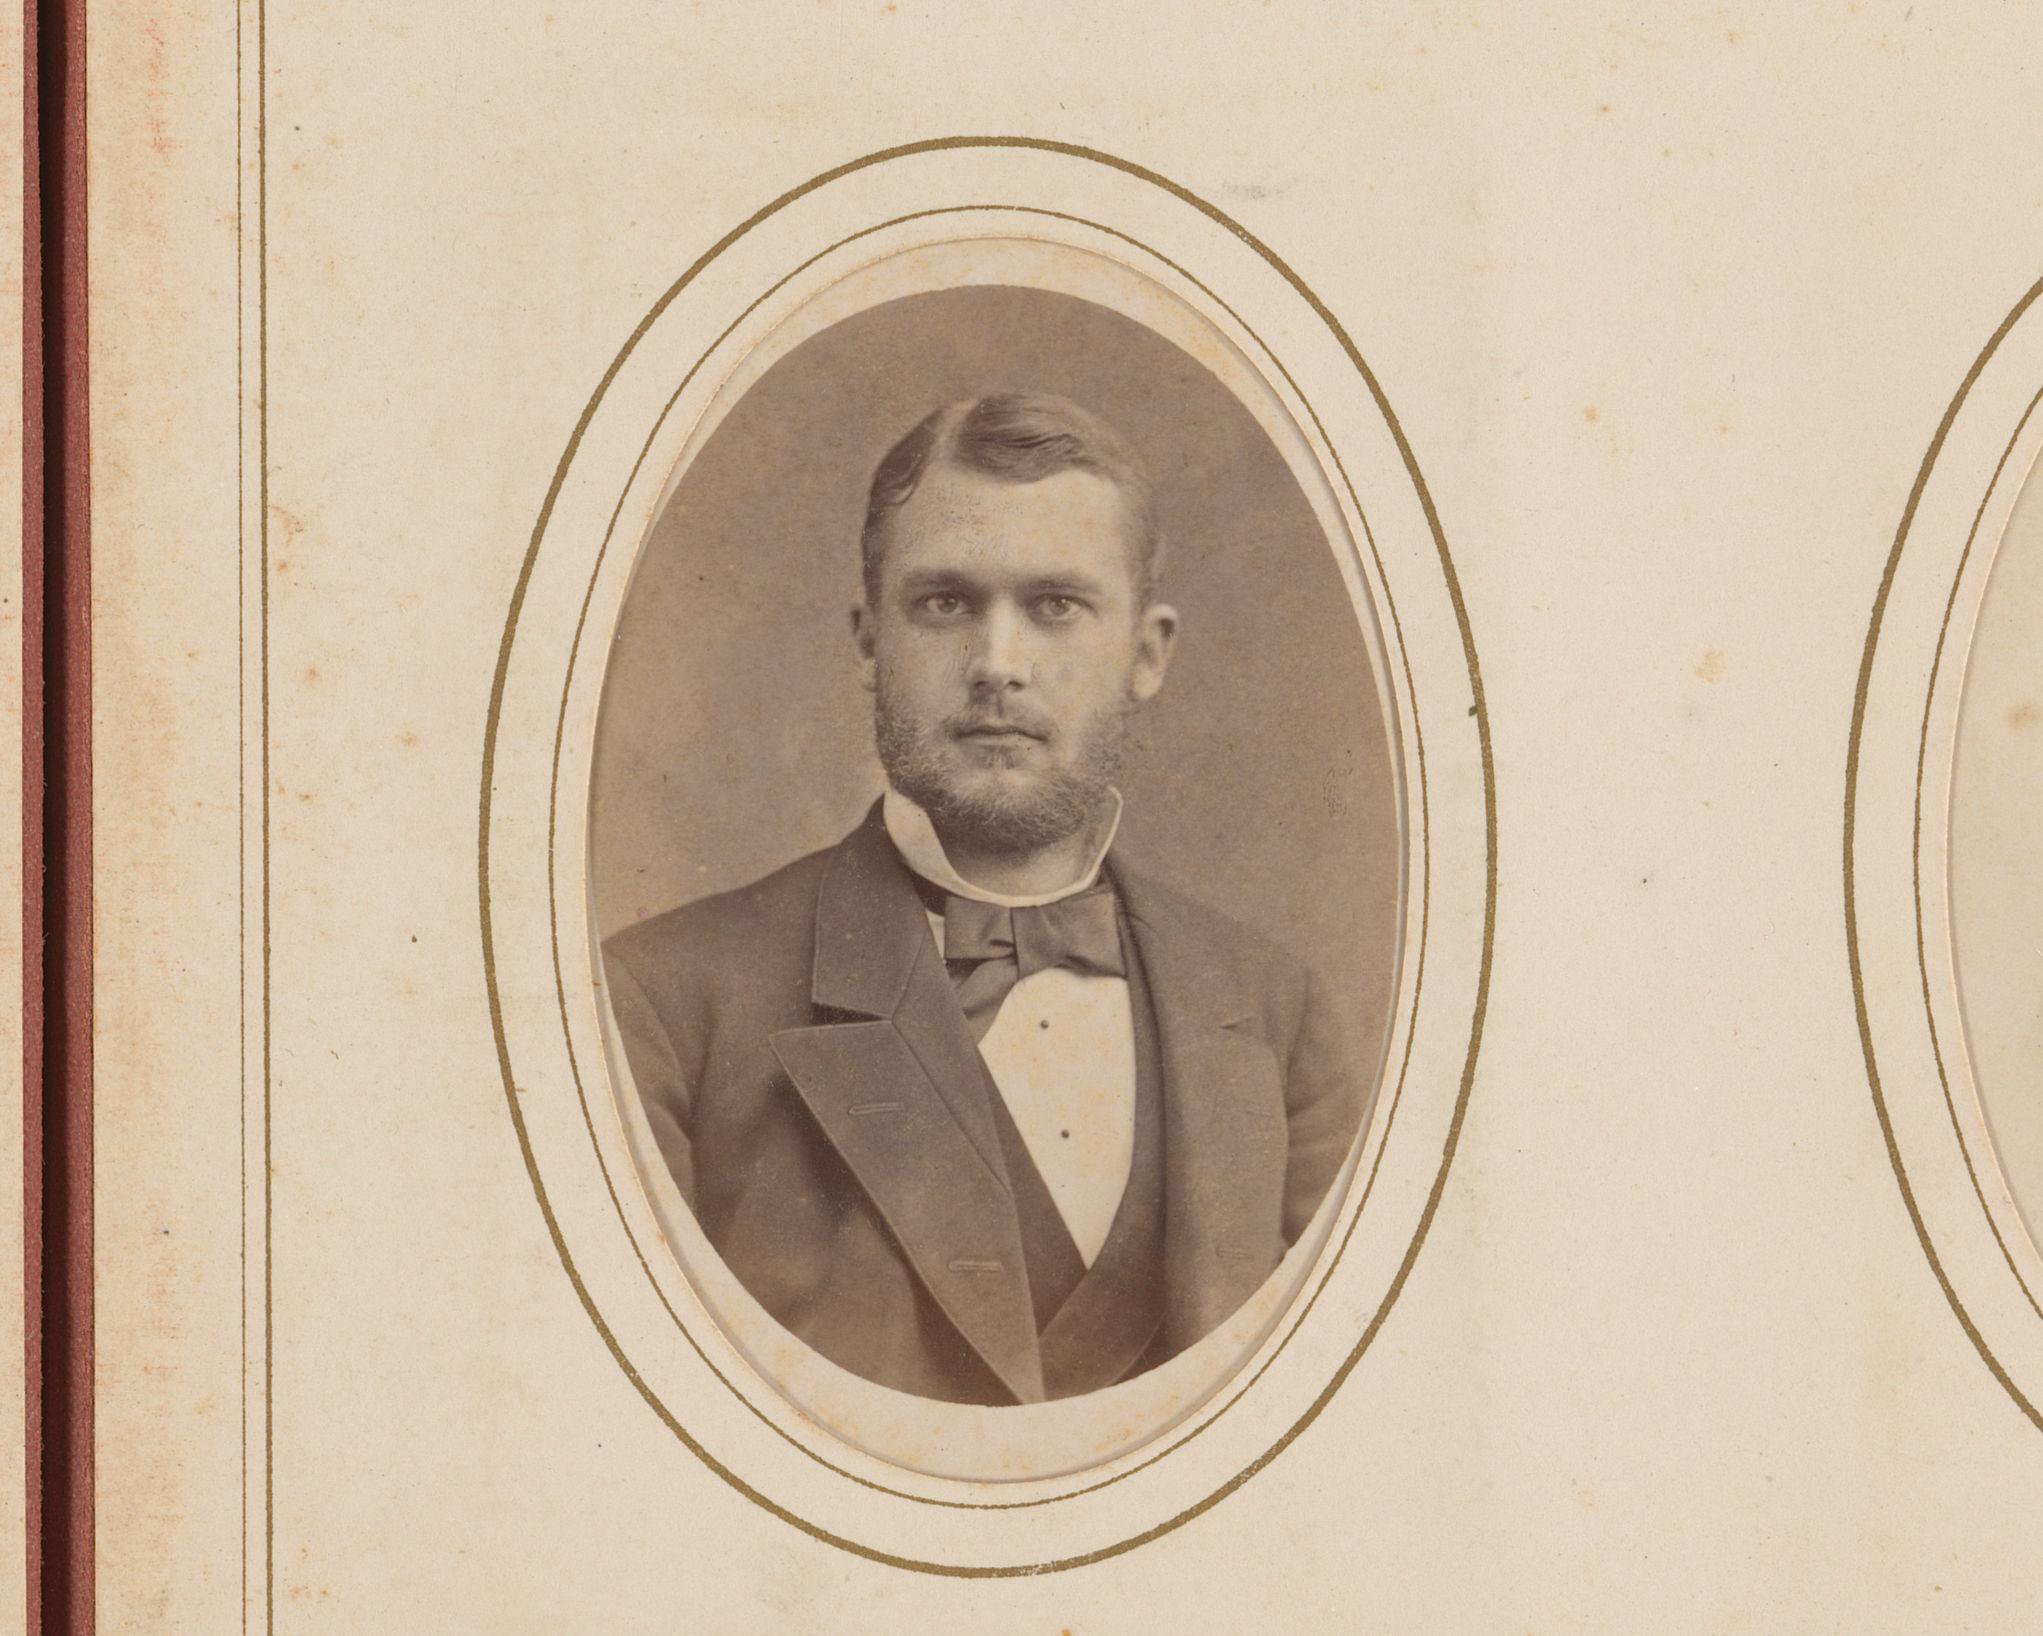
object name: album leaf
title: Portret van een man met baard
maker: max büttinghausen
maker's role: fotograaf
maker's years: 1847-1906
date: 1877-1895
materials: cardboard, photographic support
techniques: albumen print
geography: amsterdam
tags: historical persons, beard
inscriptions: inscription: ‘Amsterdam/ 1877./ M. Büttinghausen/ Photographisch artistisch Atelier/ Singel b/d Torensteeg/ G 133/ Amsterdam/ Specialiteit in vergrootingen./ De plaat blijft ter nabestelling bewaard.’